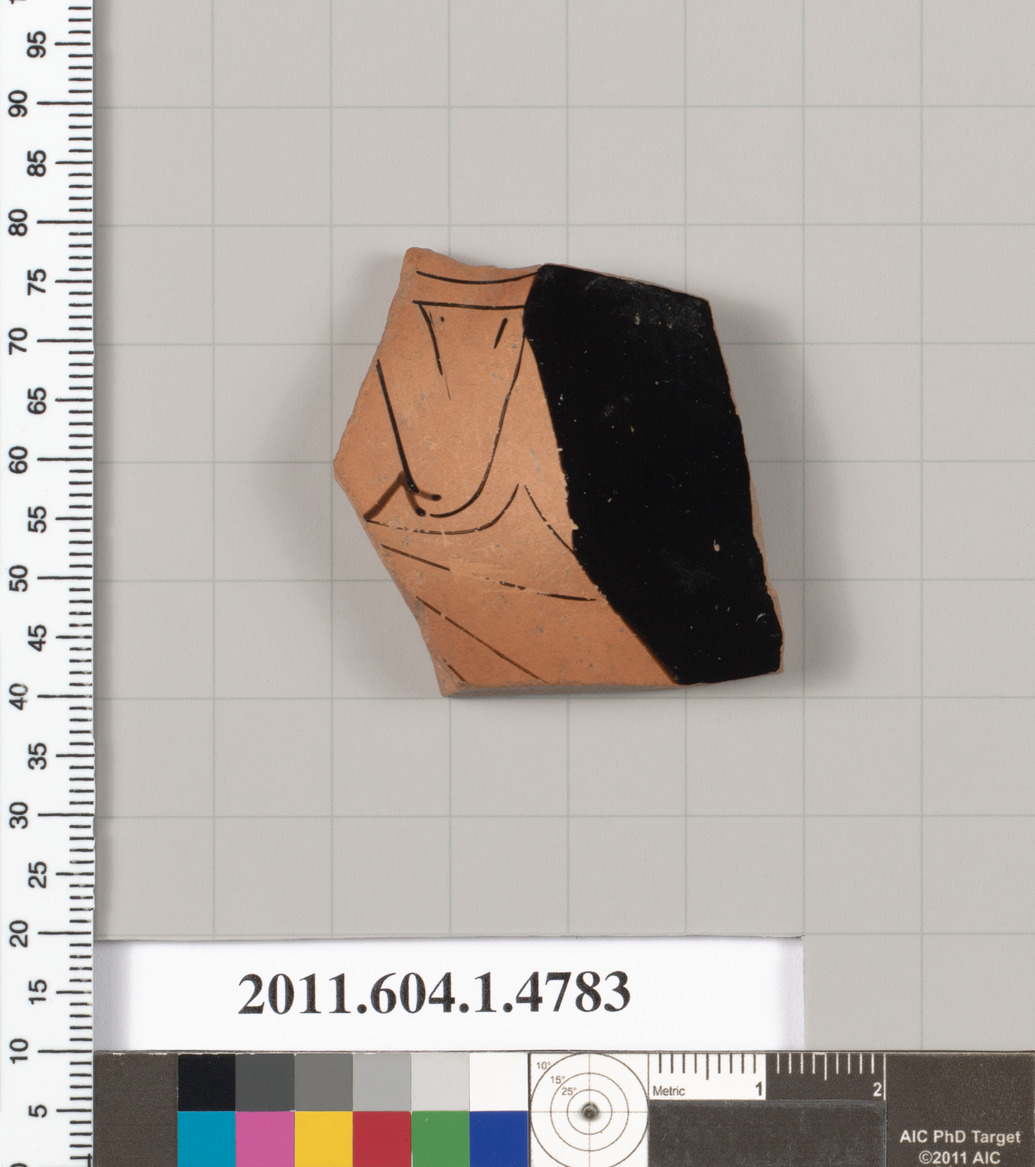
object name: kylix fragment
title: Terracotta fragment of a kylix (drinking cup)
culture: greek, attic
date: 475-451 BCE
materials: terracotta